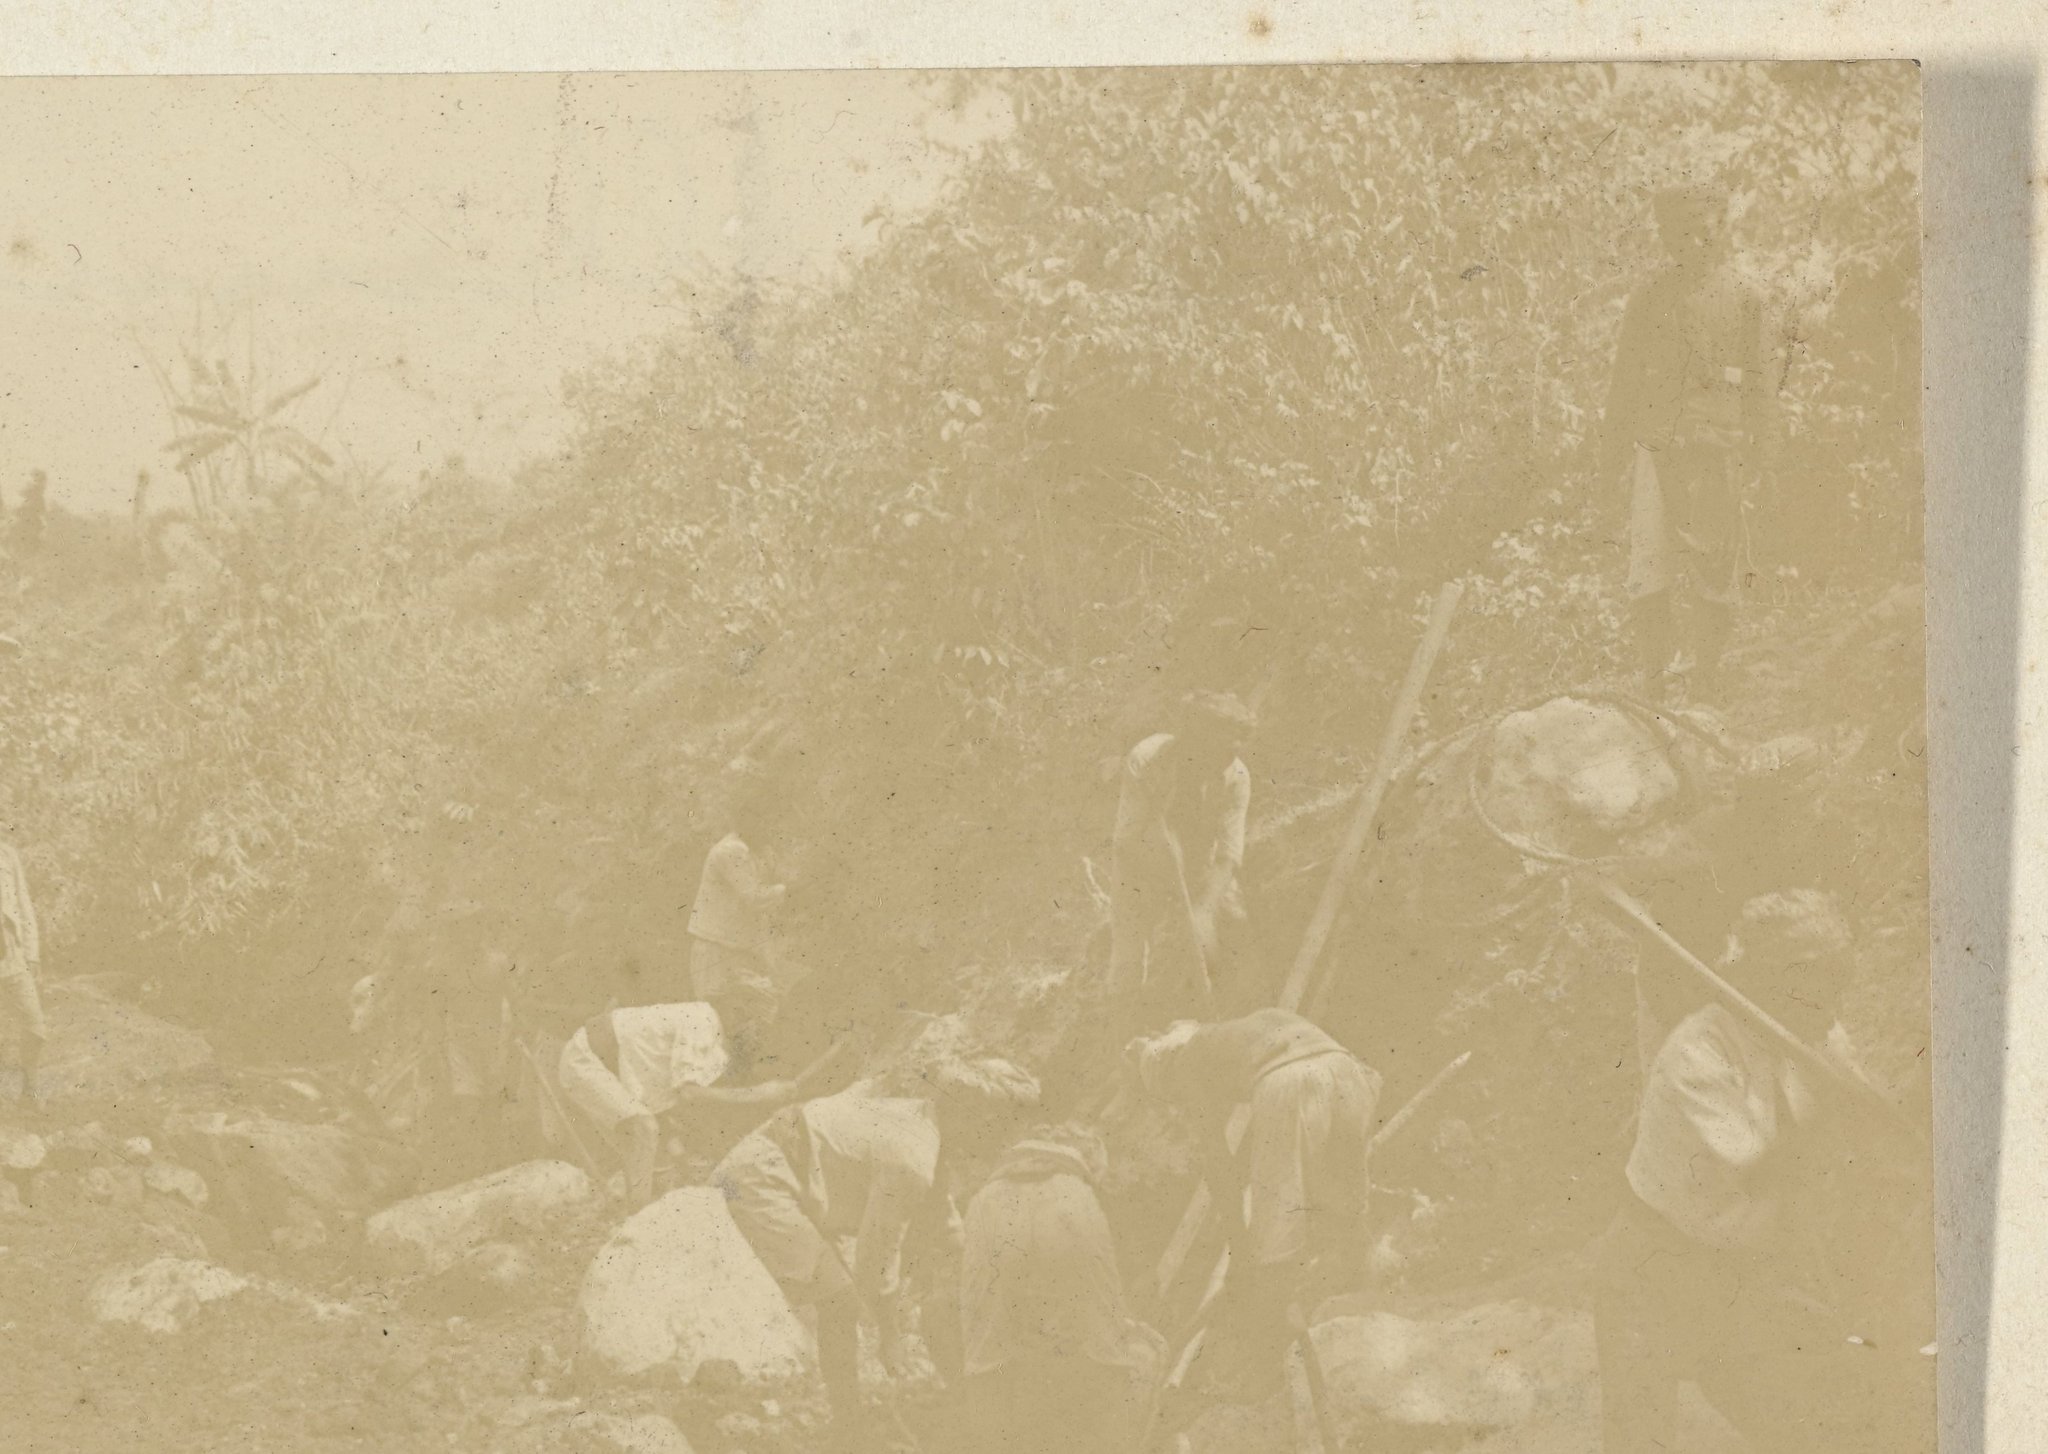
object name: photograph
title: Uithakken van rotsblokken.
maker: Anonymous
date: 1890-1910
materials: cardboard, paper, photographic support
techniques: gelatin silver print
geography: indonesia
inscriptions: caption: ‘5 kiekjes te Djattie roenggo’